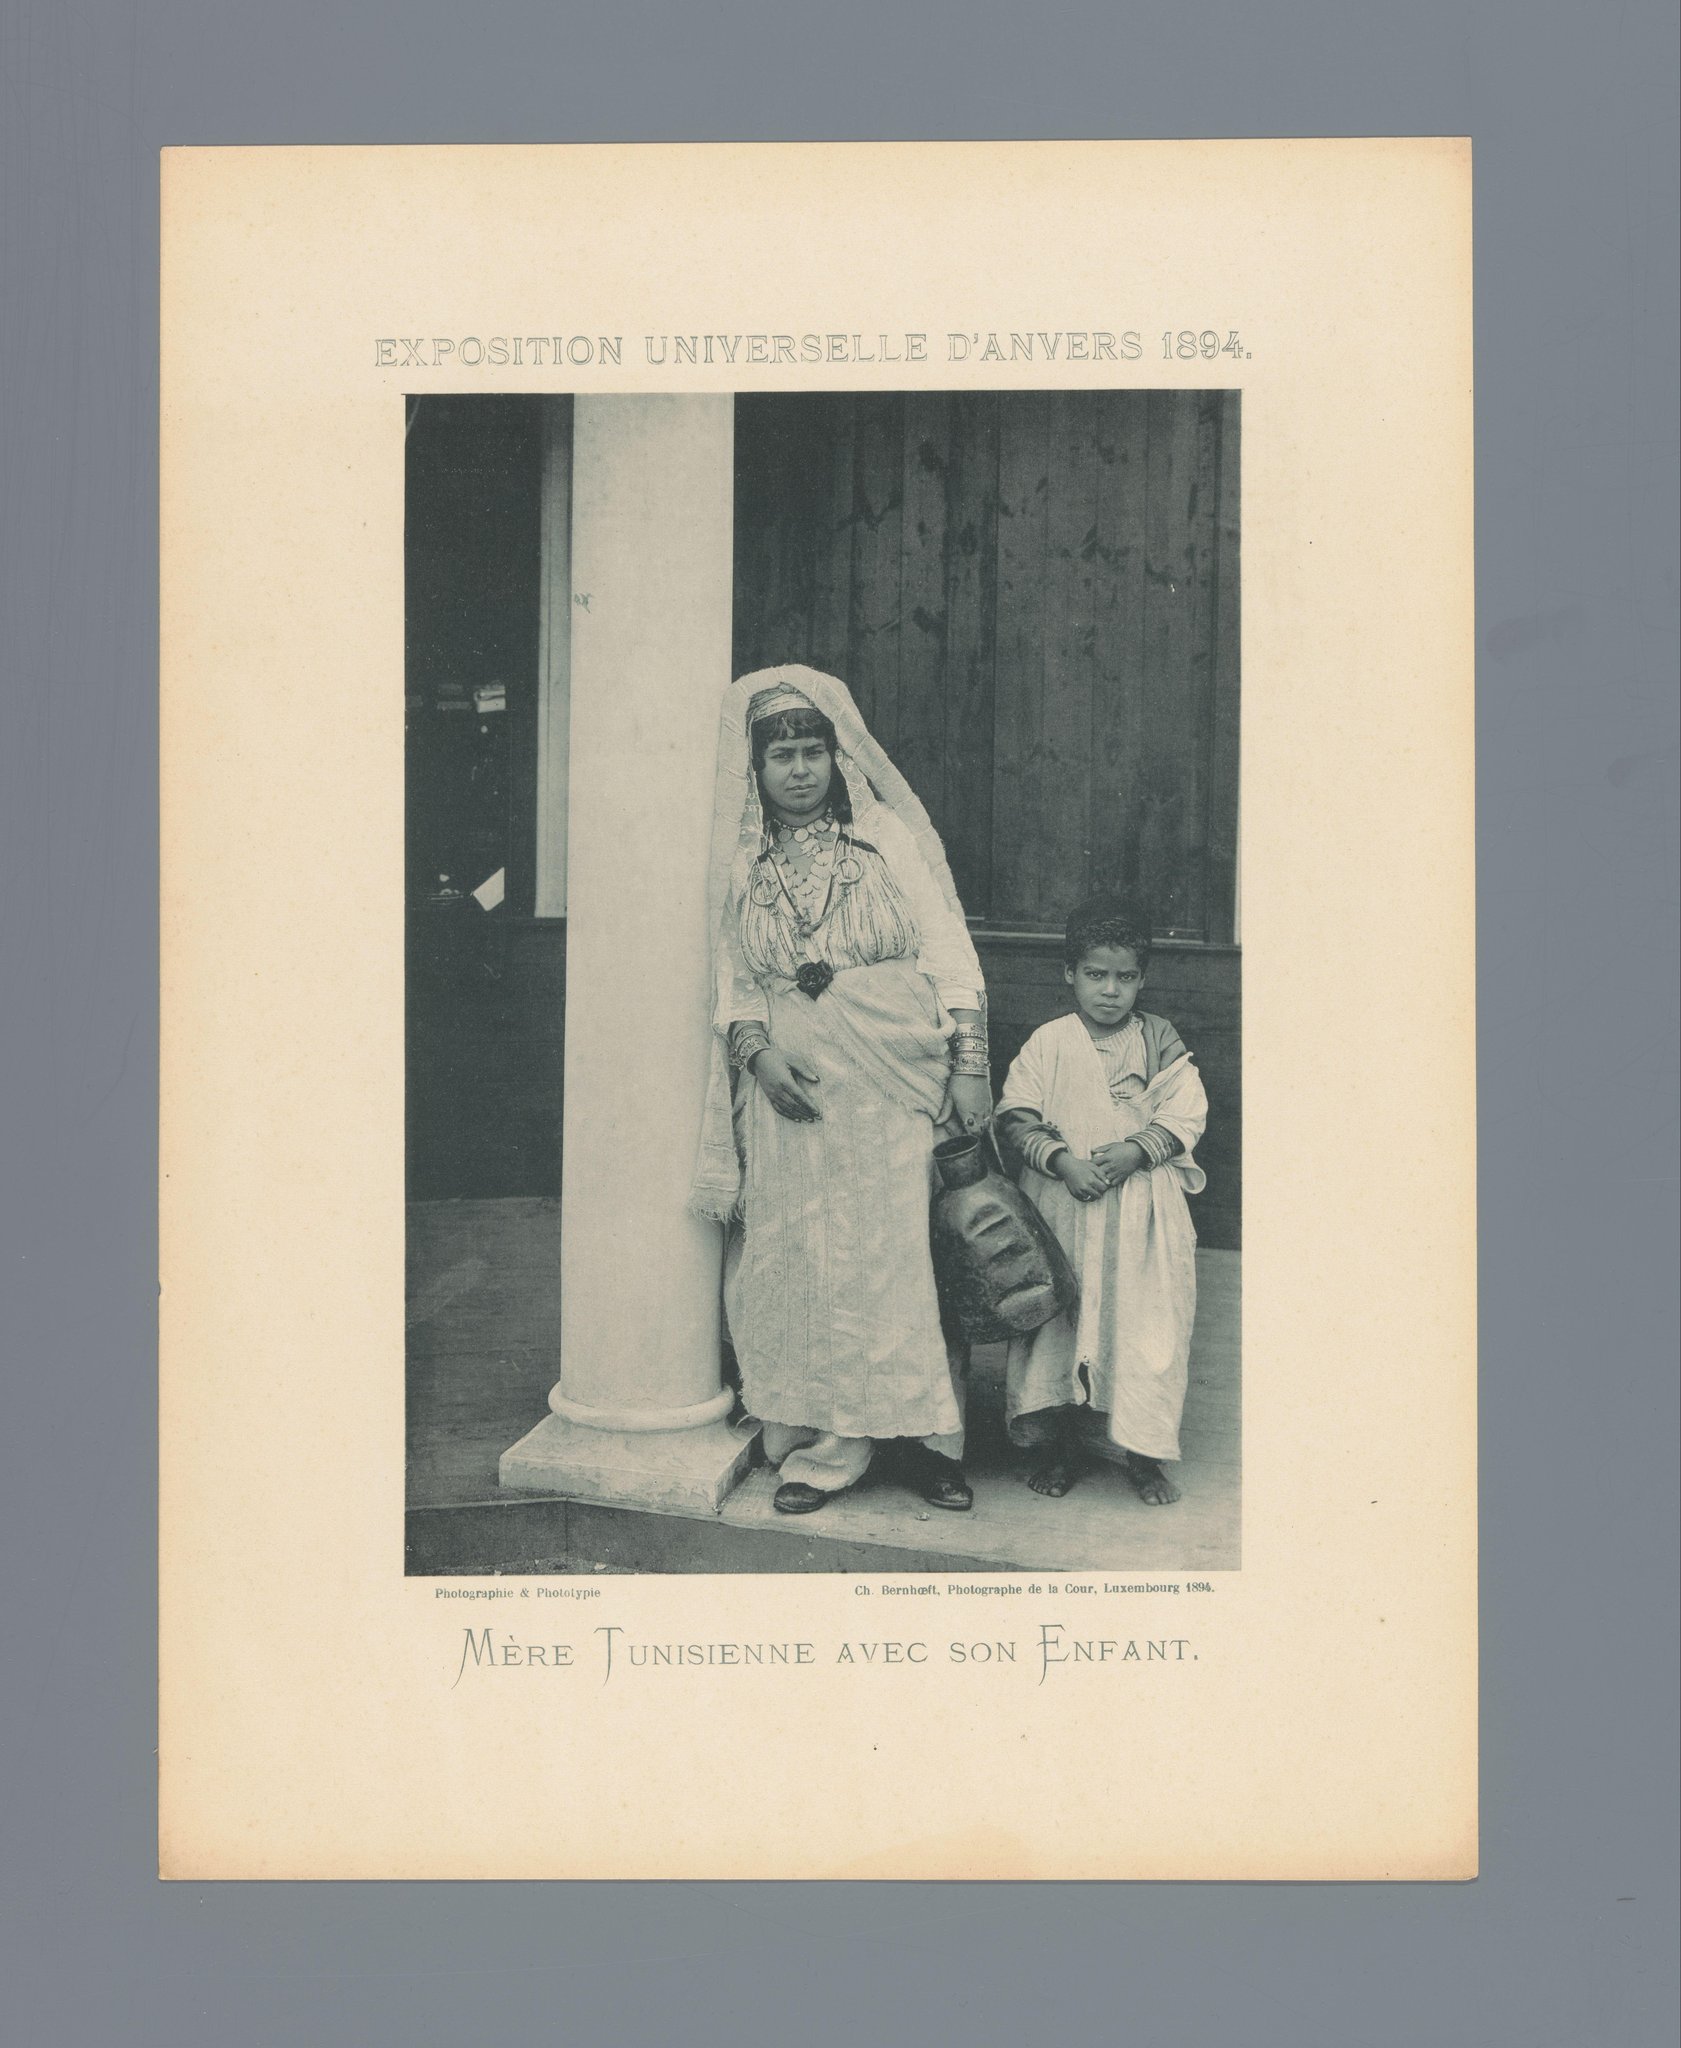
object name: photomechanical print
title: Mère tunisienne avec son enfant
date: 1894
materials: paper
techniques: photograph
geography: antwerp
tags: world fair, world exhibition, mother with son(s) (mother-love), asiatic races and peoples (with name), antwerp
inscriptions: inscription: ‘Exposition Universelle D'Anvers 1894’